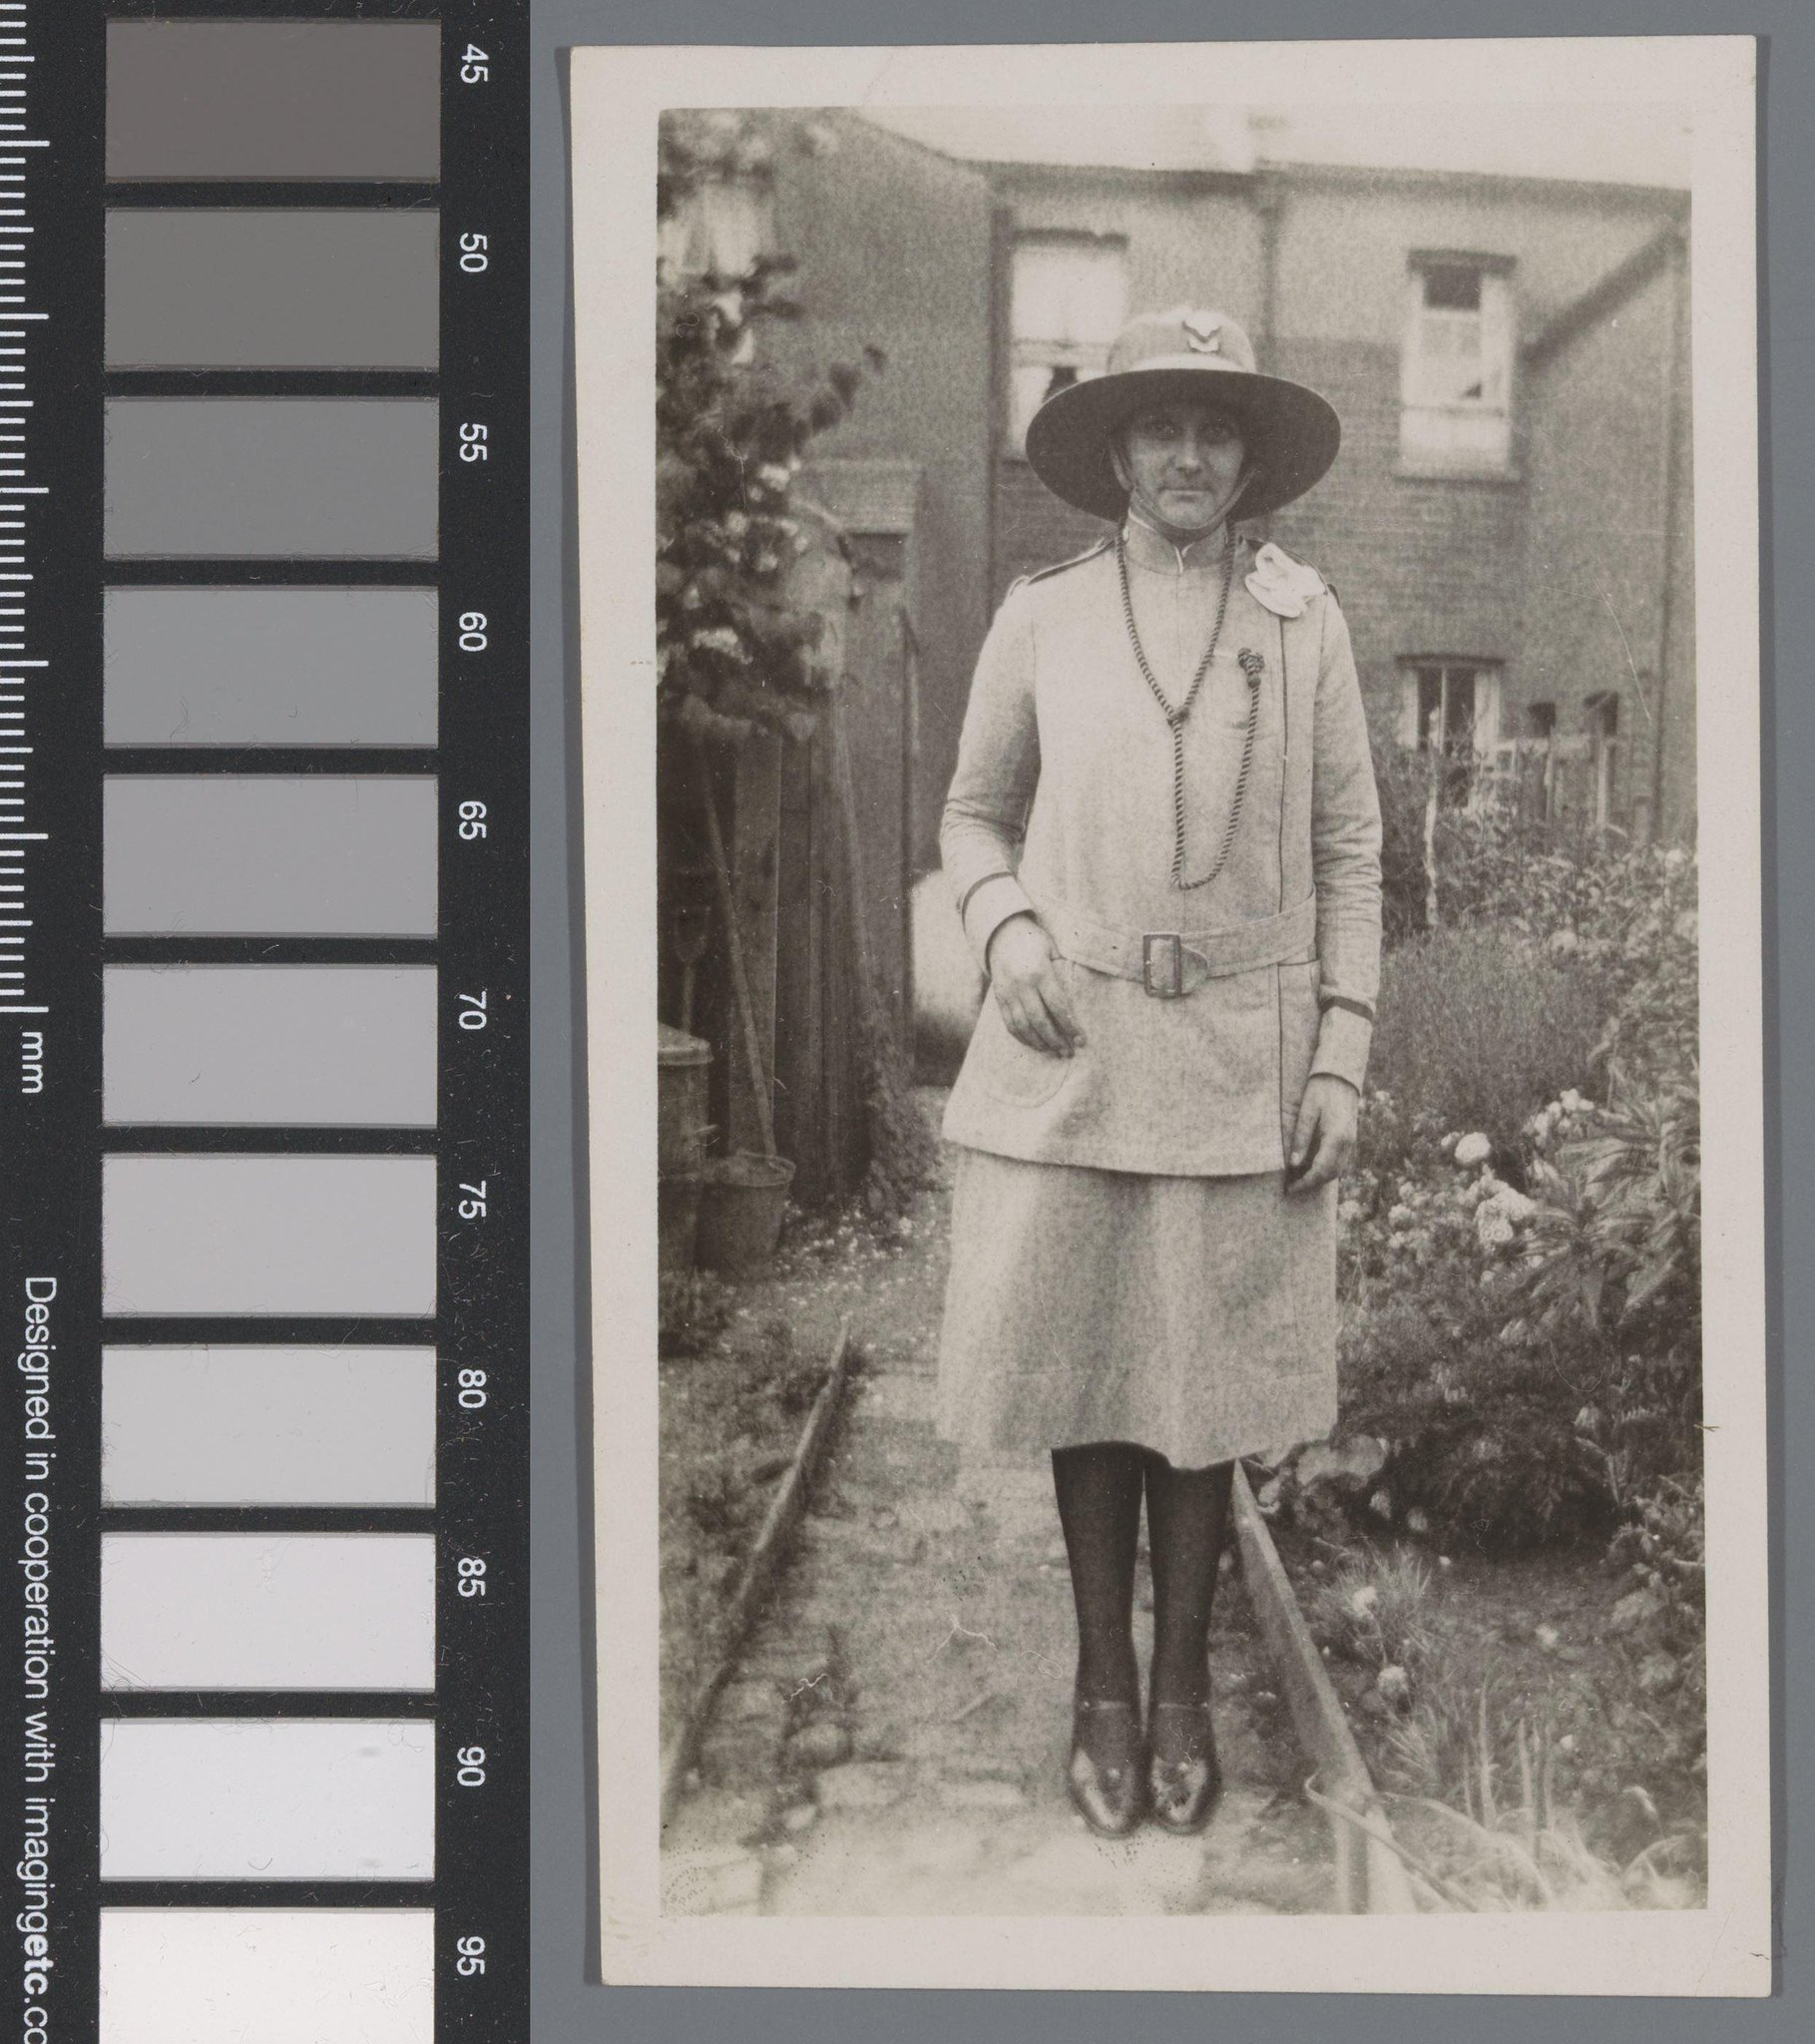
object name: photograph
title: Portret van een onbekende vrouw met een hoed in een achtertuin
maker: Anonymous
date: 1920-1940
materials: photographic support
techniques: gelatin silver print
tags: adult woman, head-gear: hat, backyard